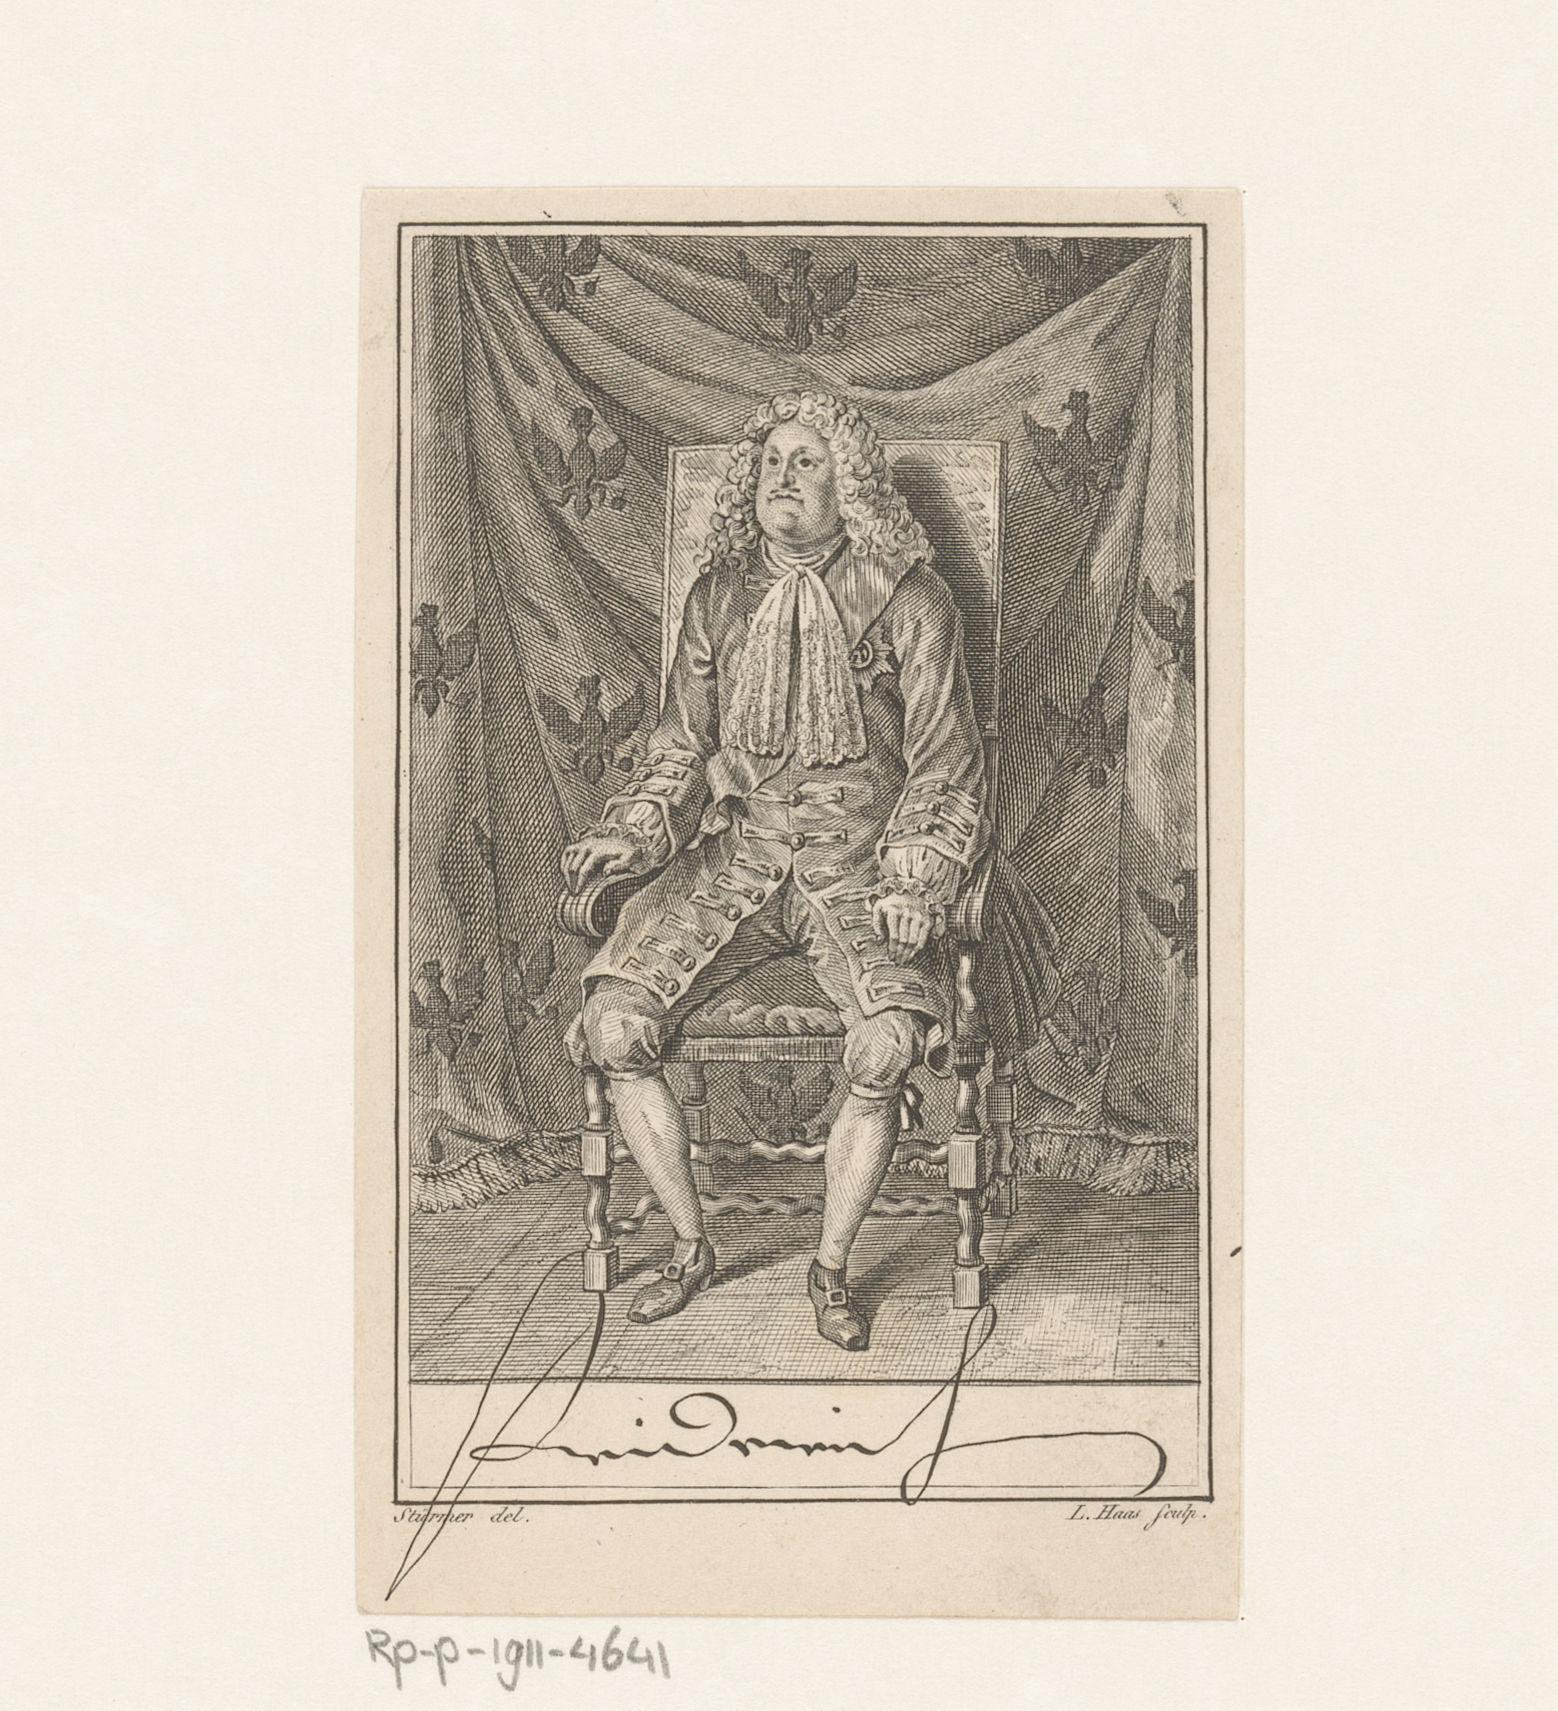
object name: print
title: Portret van Friedrich I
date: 1800-1899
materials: paper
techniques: engraving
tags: berlin, friedrich i (koning van pruisen), double-headed eagle, historical persons, throne, ruler, sovereign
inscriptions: collector's mark: Lugt 2228